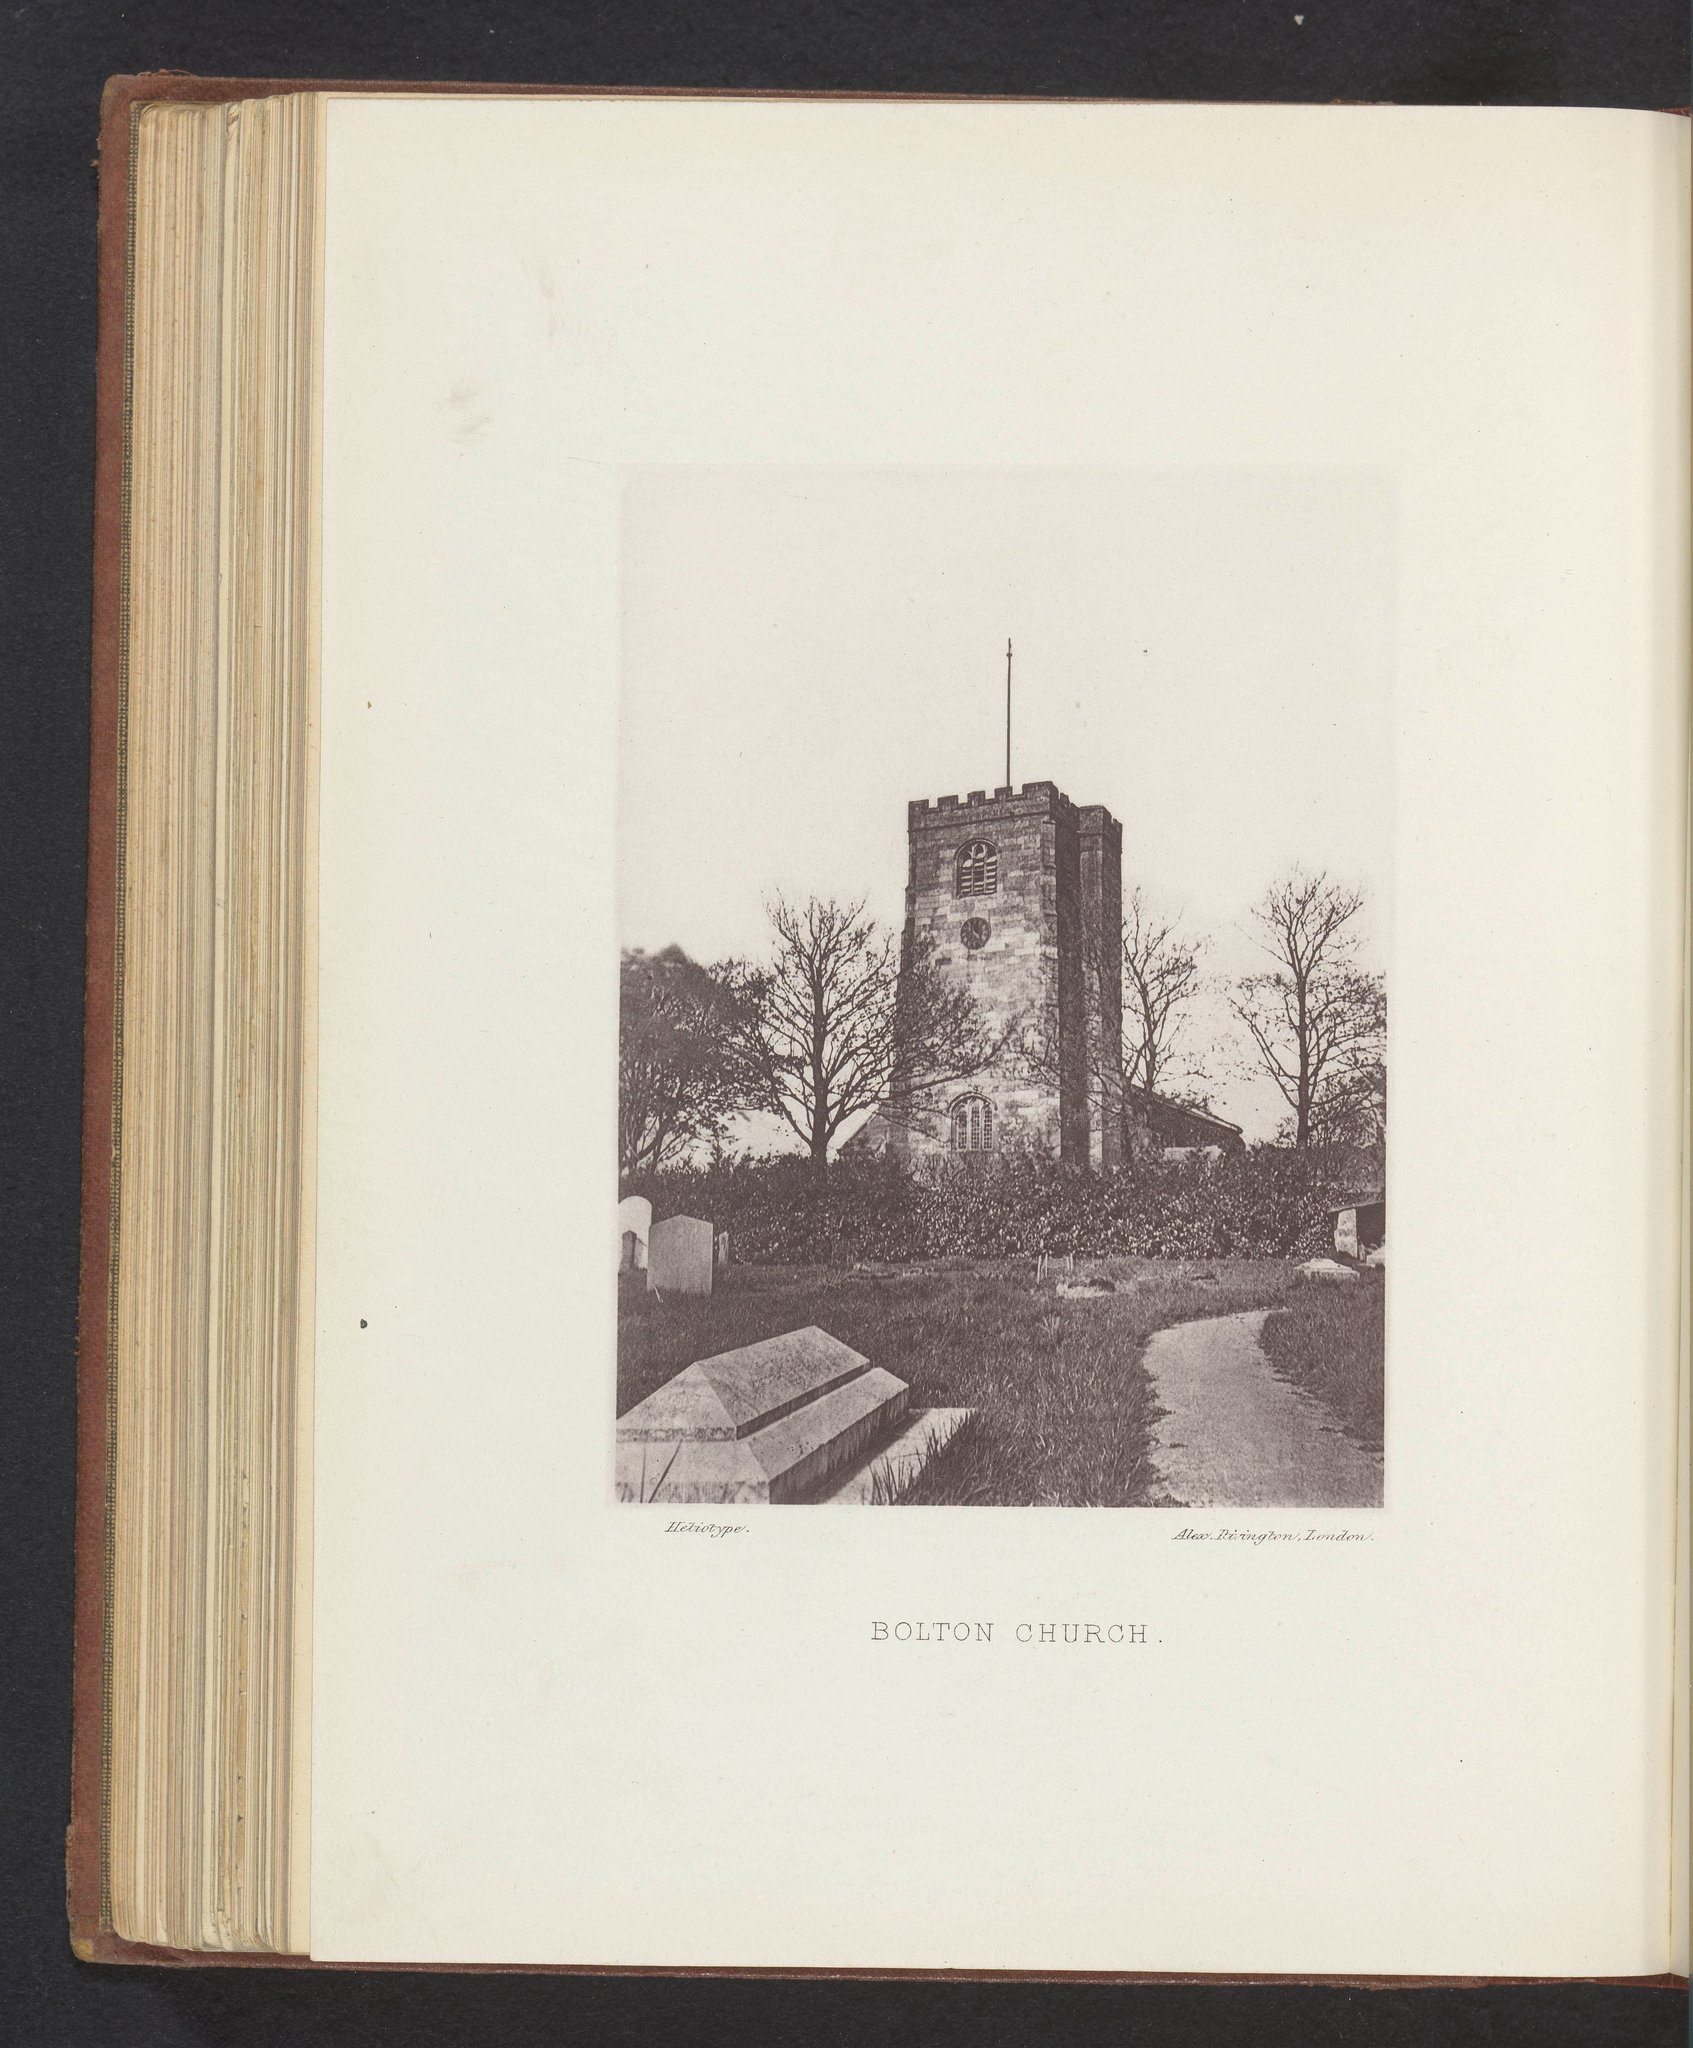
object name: photomechanical print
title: Bolton church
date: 1870-1880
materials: paper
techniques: heliotype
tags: church (exterior), parts of church exterior and annexes: tower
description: Prent tegenover pagina 1 van het achterste katern.